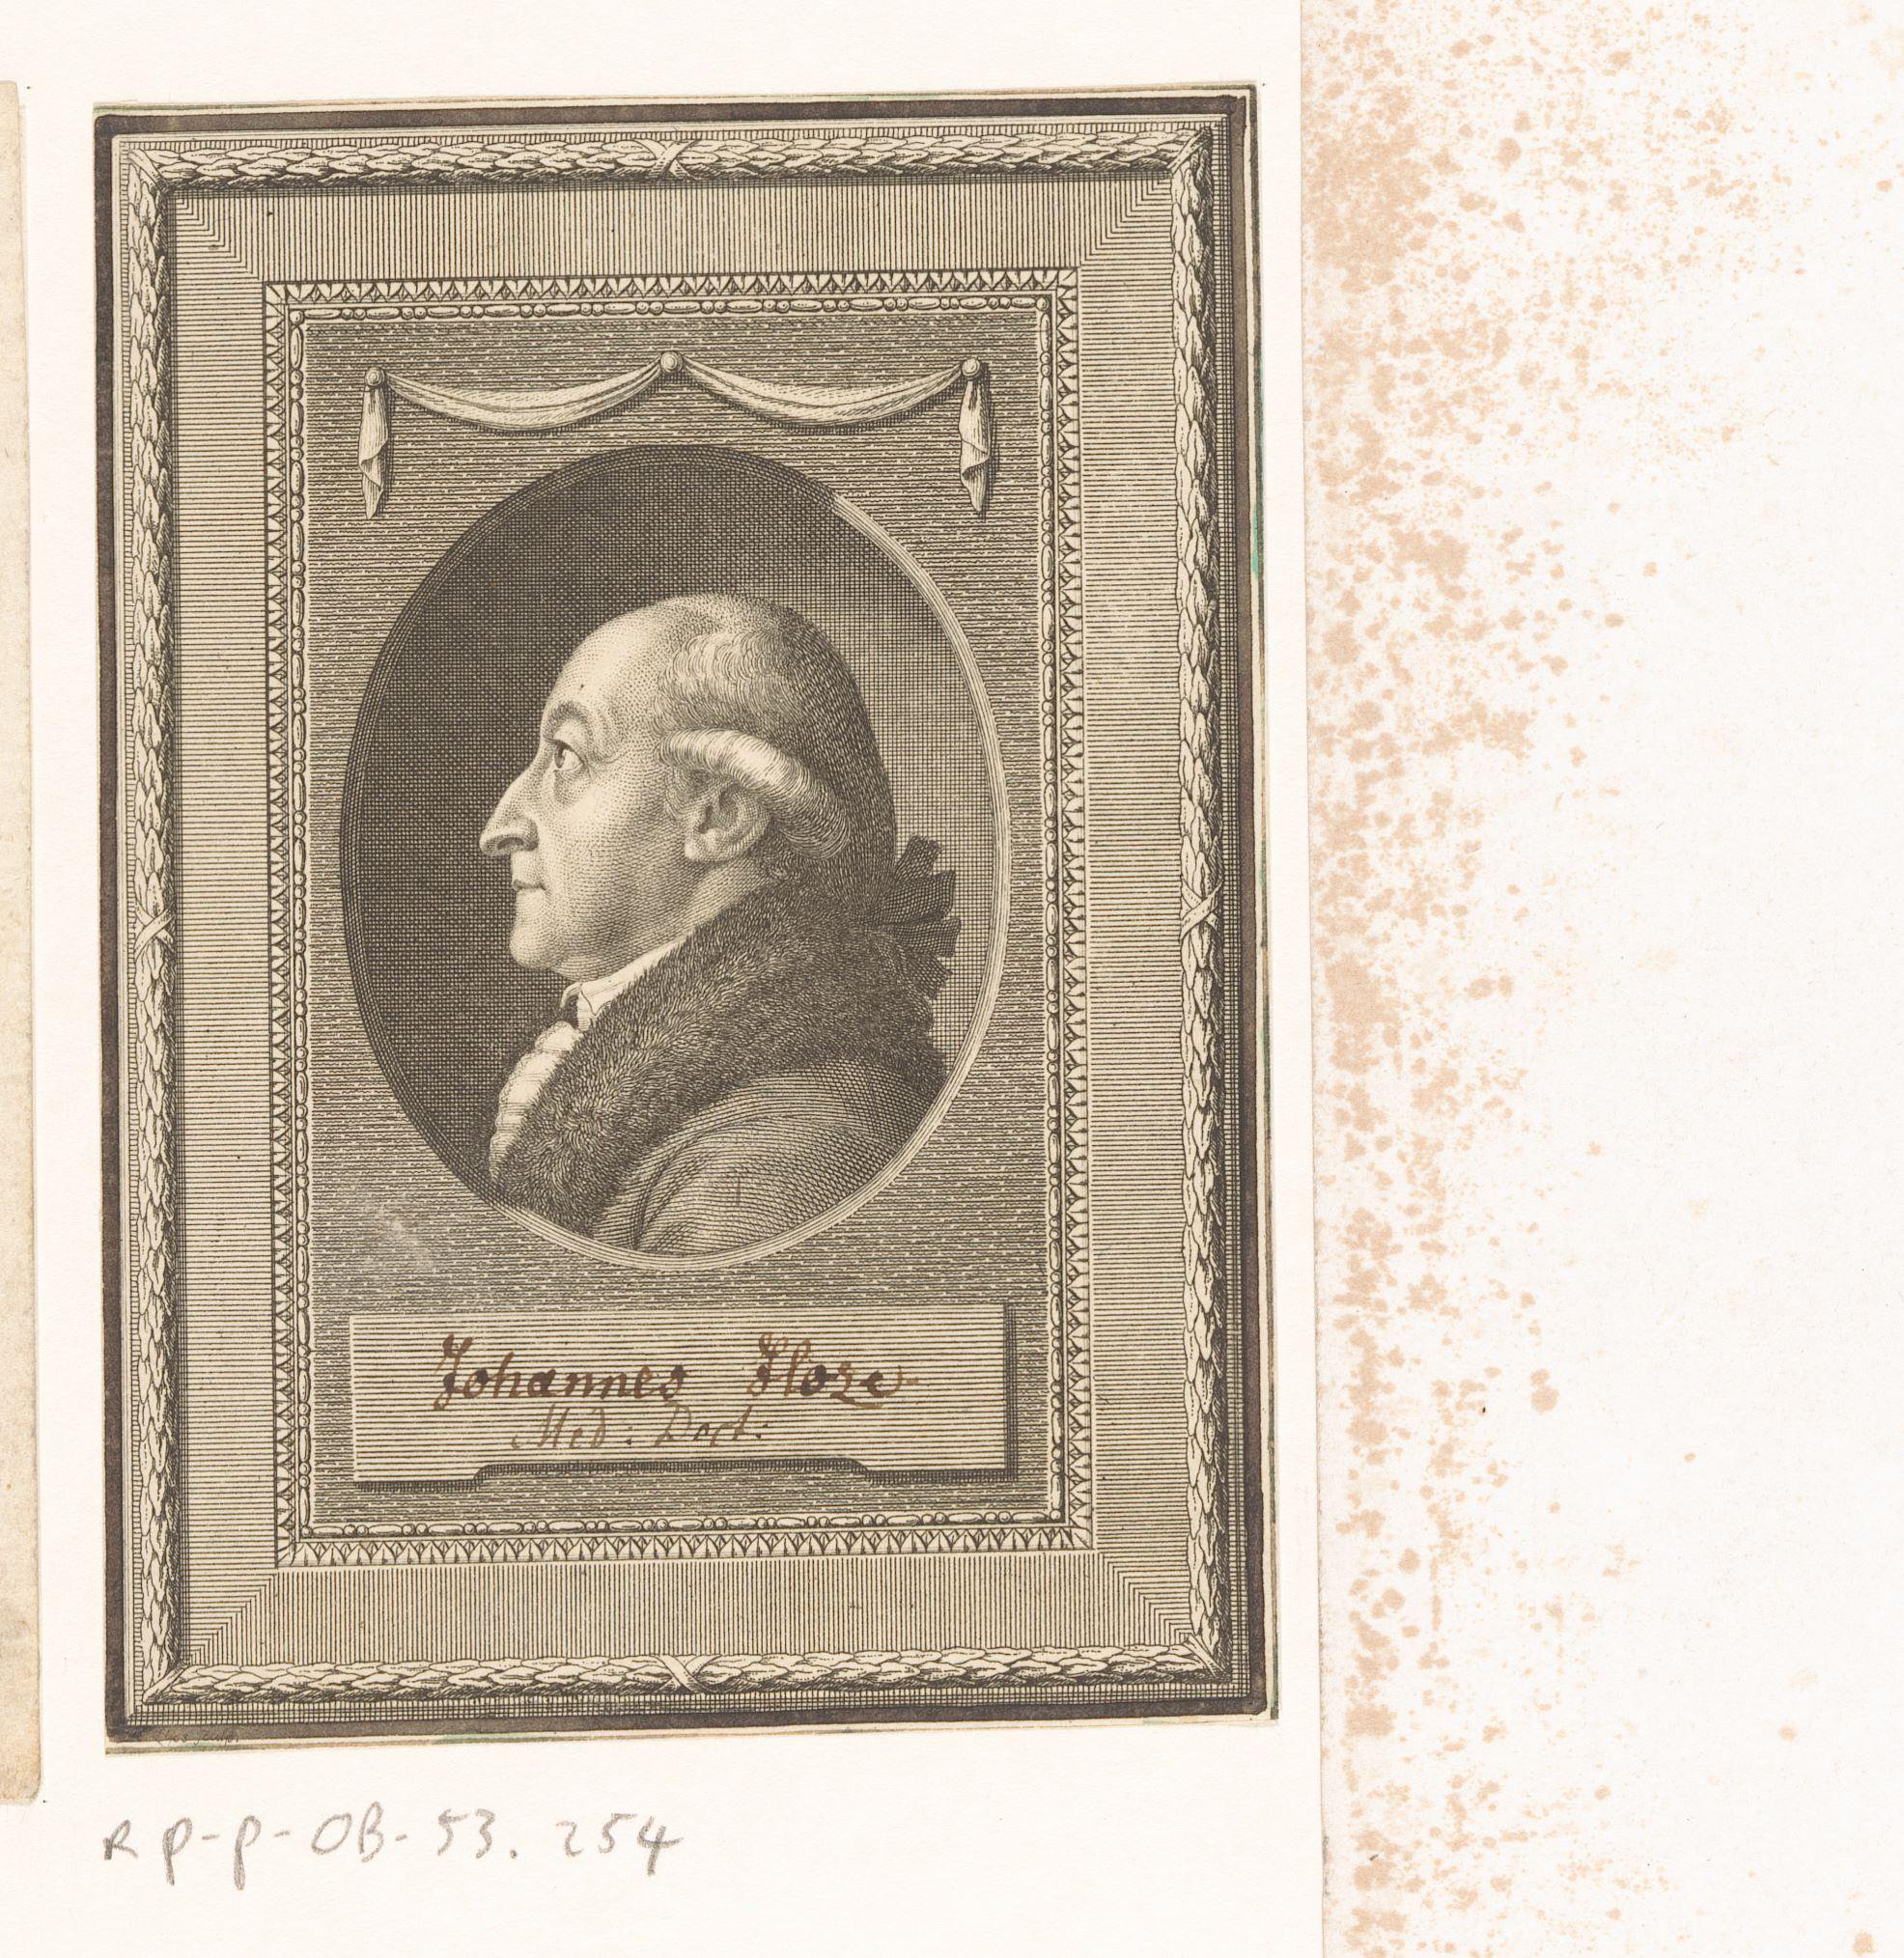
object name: print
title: Portret van Johannes Hoze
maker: johann heinrich lips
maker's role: draughtsman, painter, print maker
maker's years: 1758-1817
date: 1768-1817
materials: paper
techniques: engraving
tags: historical persons, physician, doctor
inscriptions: collector's mark: Lugt 2228